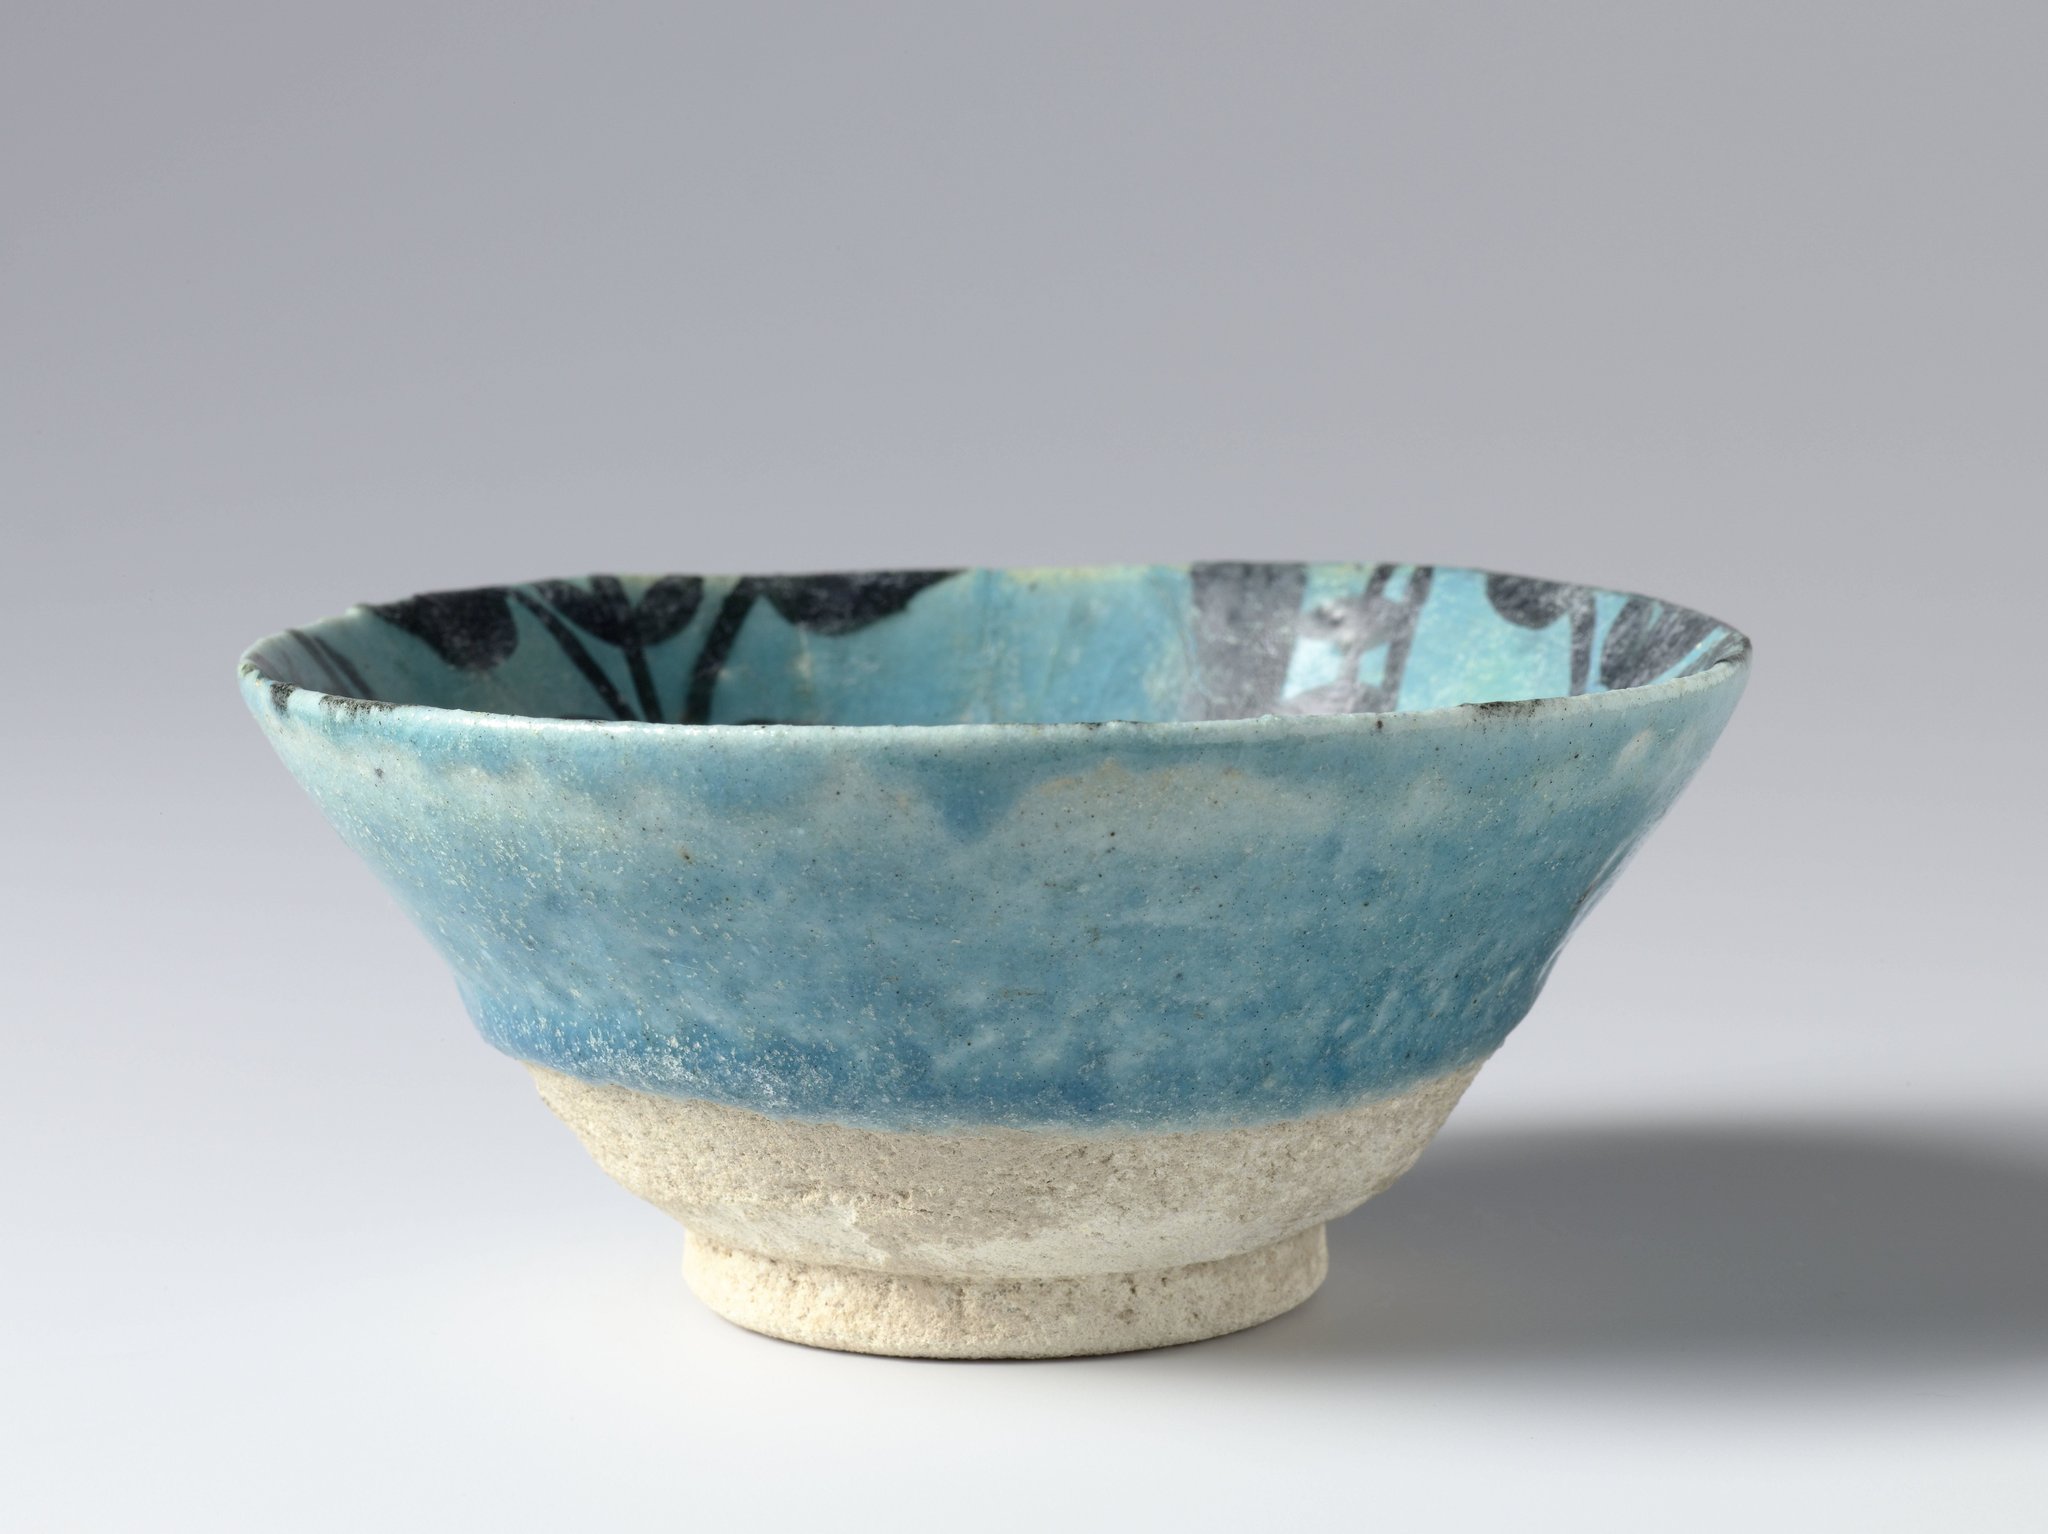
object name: bowl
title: Bowl with stylized plants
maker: Anonymous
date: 1200-1299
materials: earthenware, glaze, paint, quartz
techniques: firing, turning, vitrification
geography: iran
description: Bowl. Iran, 13th century. Stone paste. On loan from Prof. Dr J.A. Oosterbaan and Mrs Oosterbaan-Lugt.